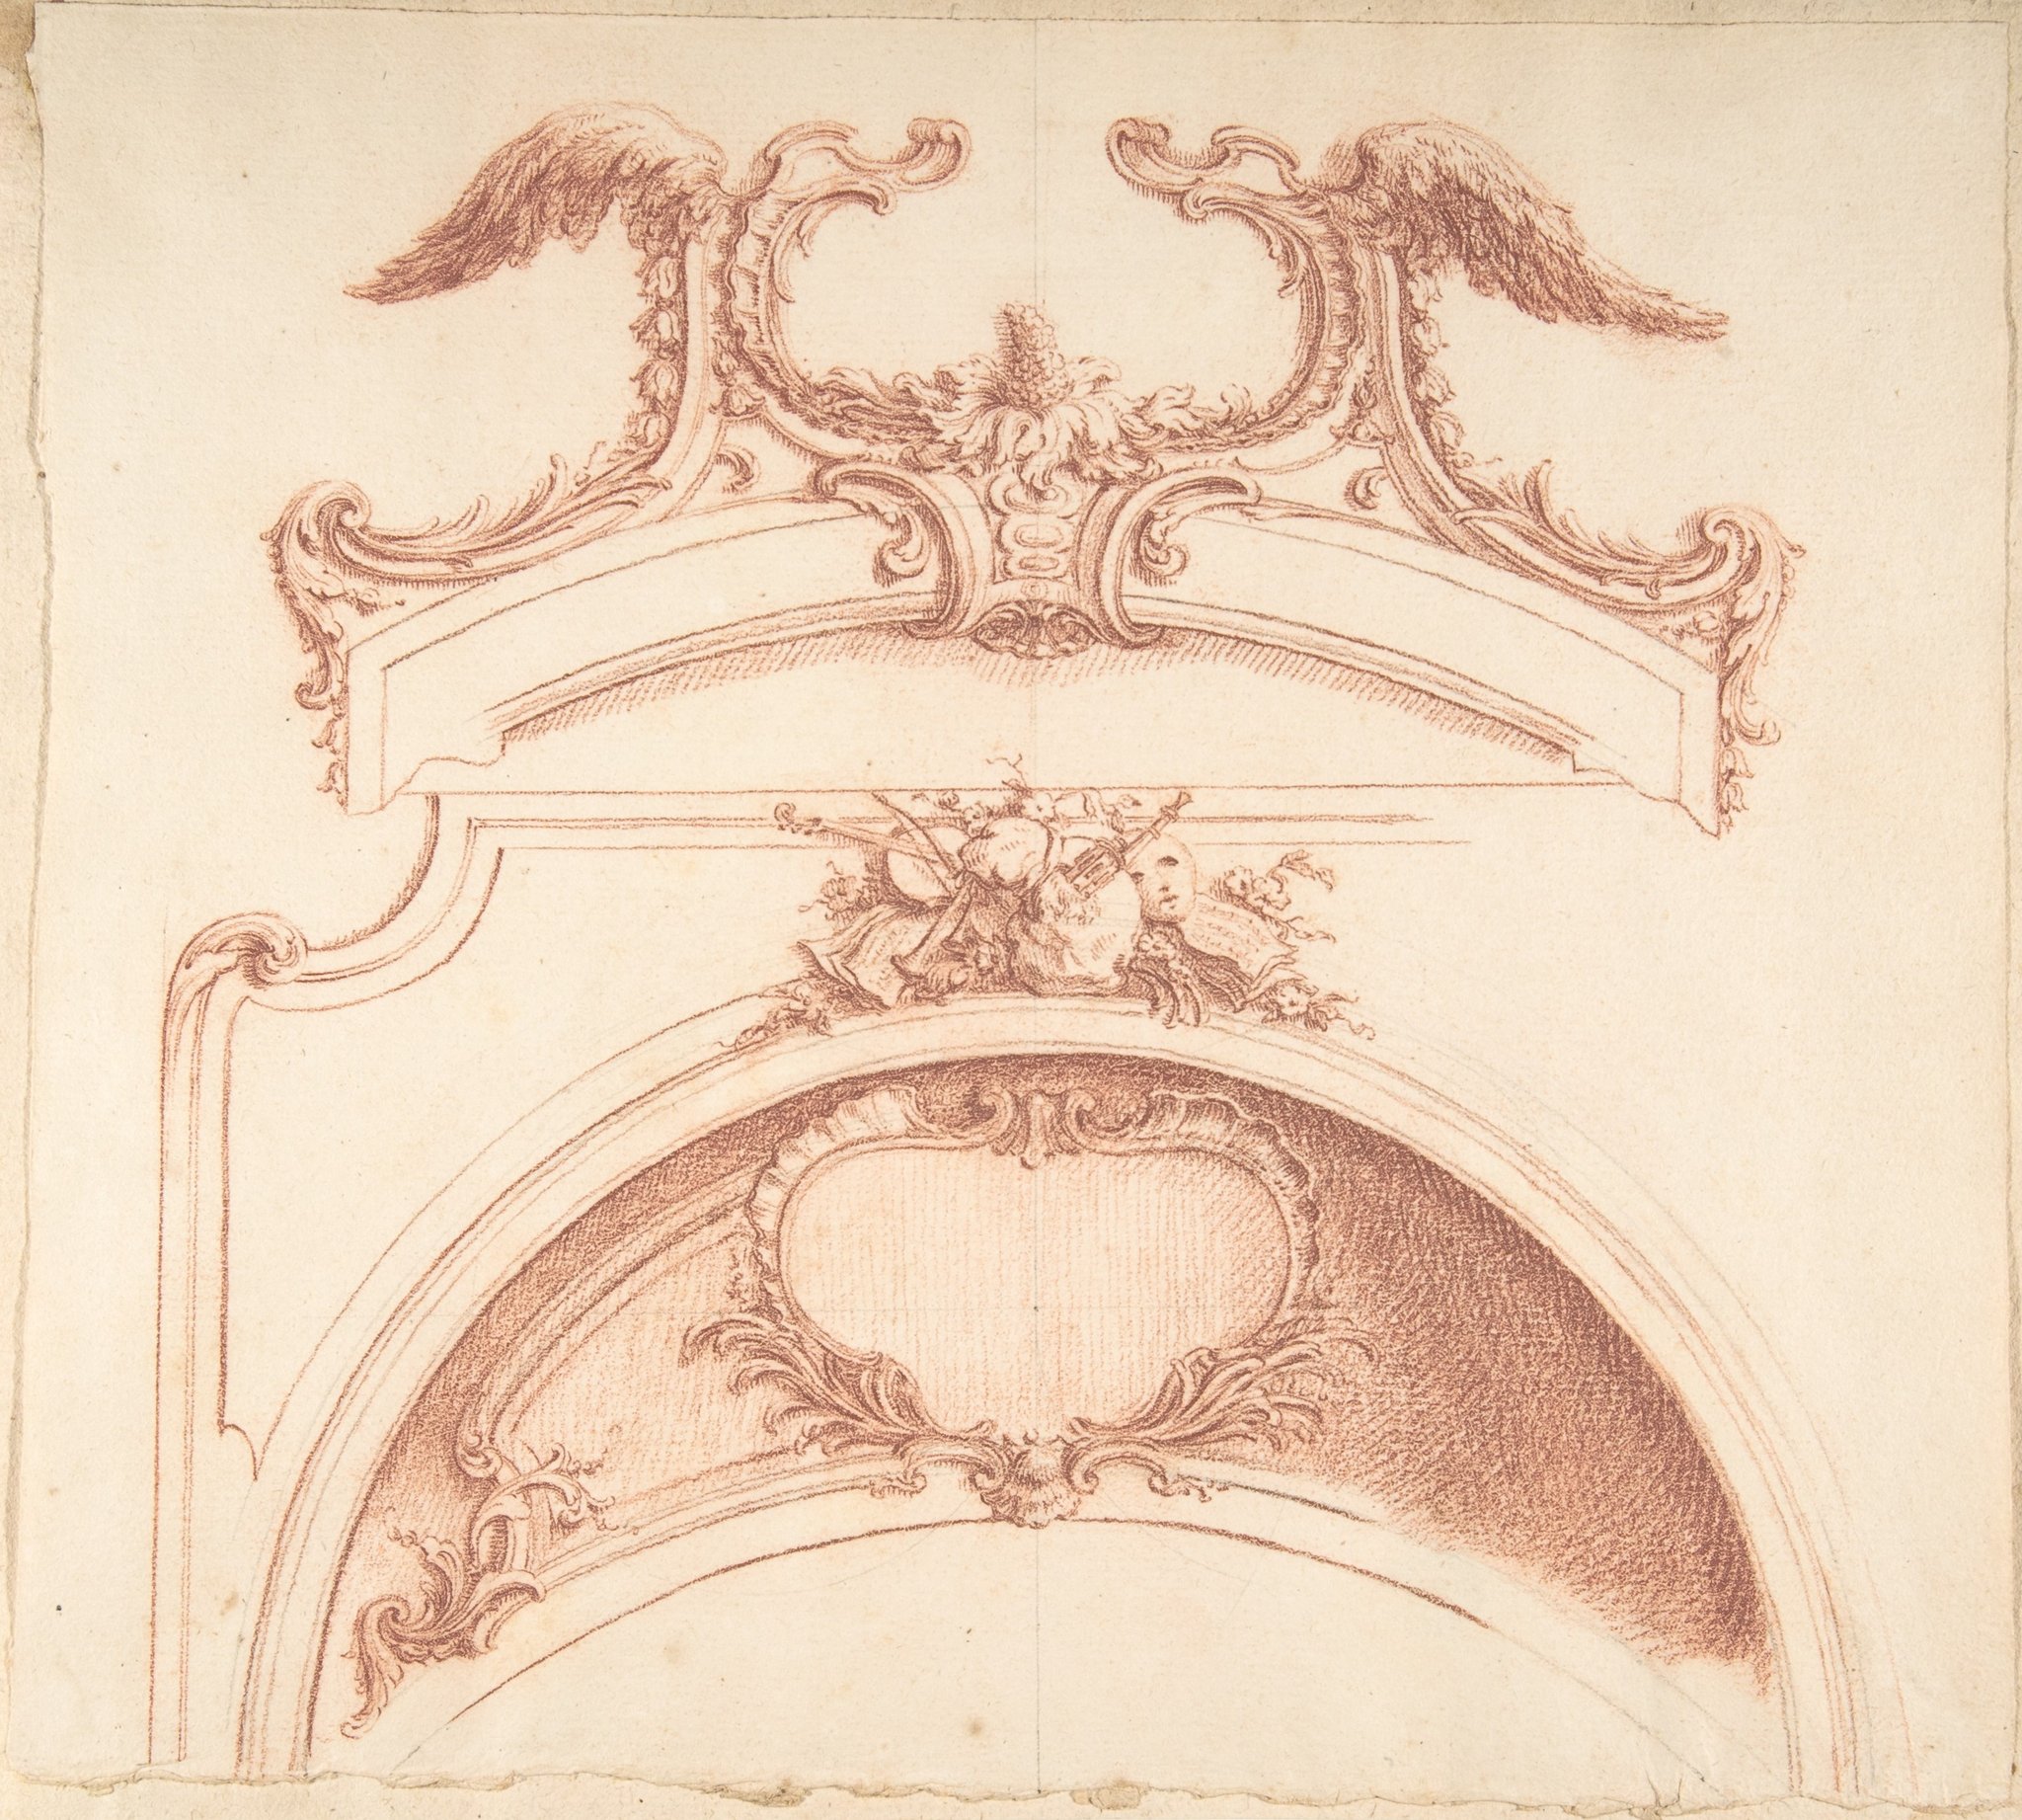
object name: drawing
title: Preparatory Studies for Plates 90 and 91 of "Maisons de plaisance," Volume II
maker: jacques françois blondel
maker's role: artist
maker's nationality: french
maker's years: 1705-1774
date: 1701-1800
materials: chalk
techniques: drawing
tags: musical instruments,birds,ornament,flowers